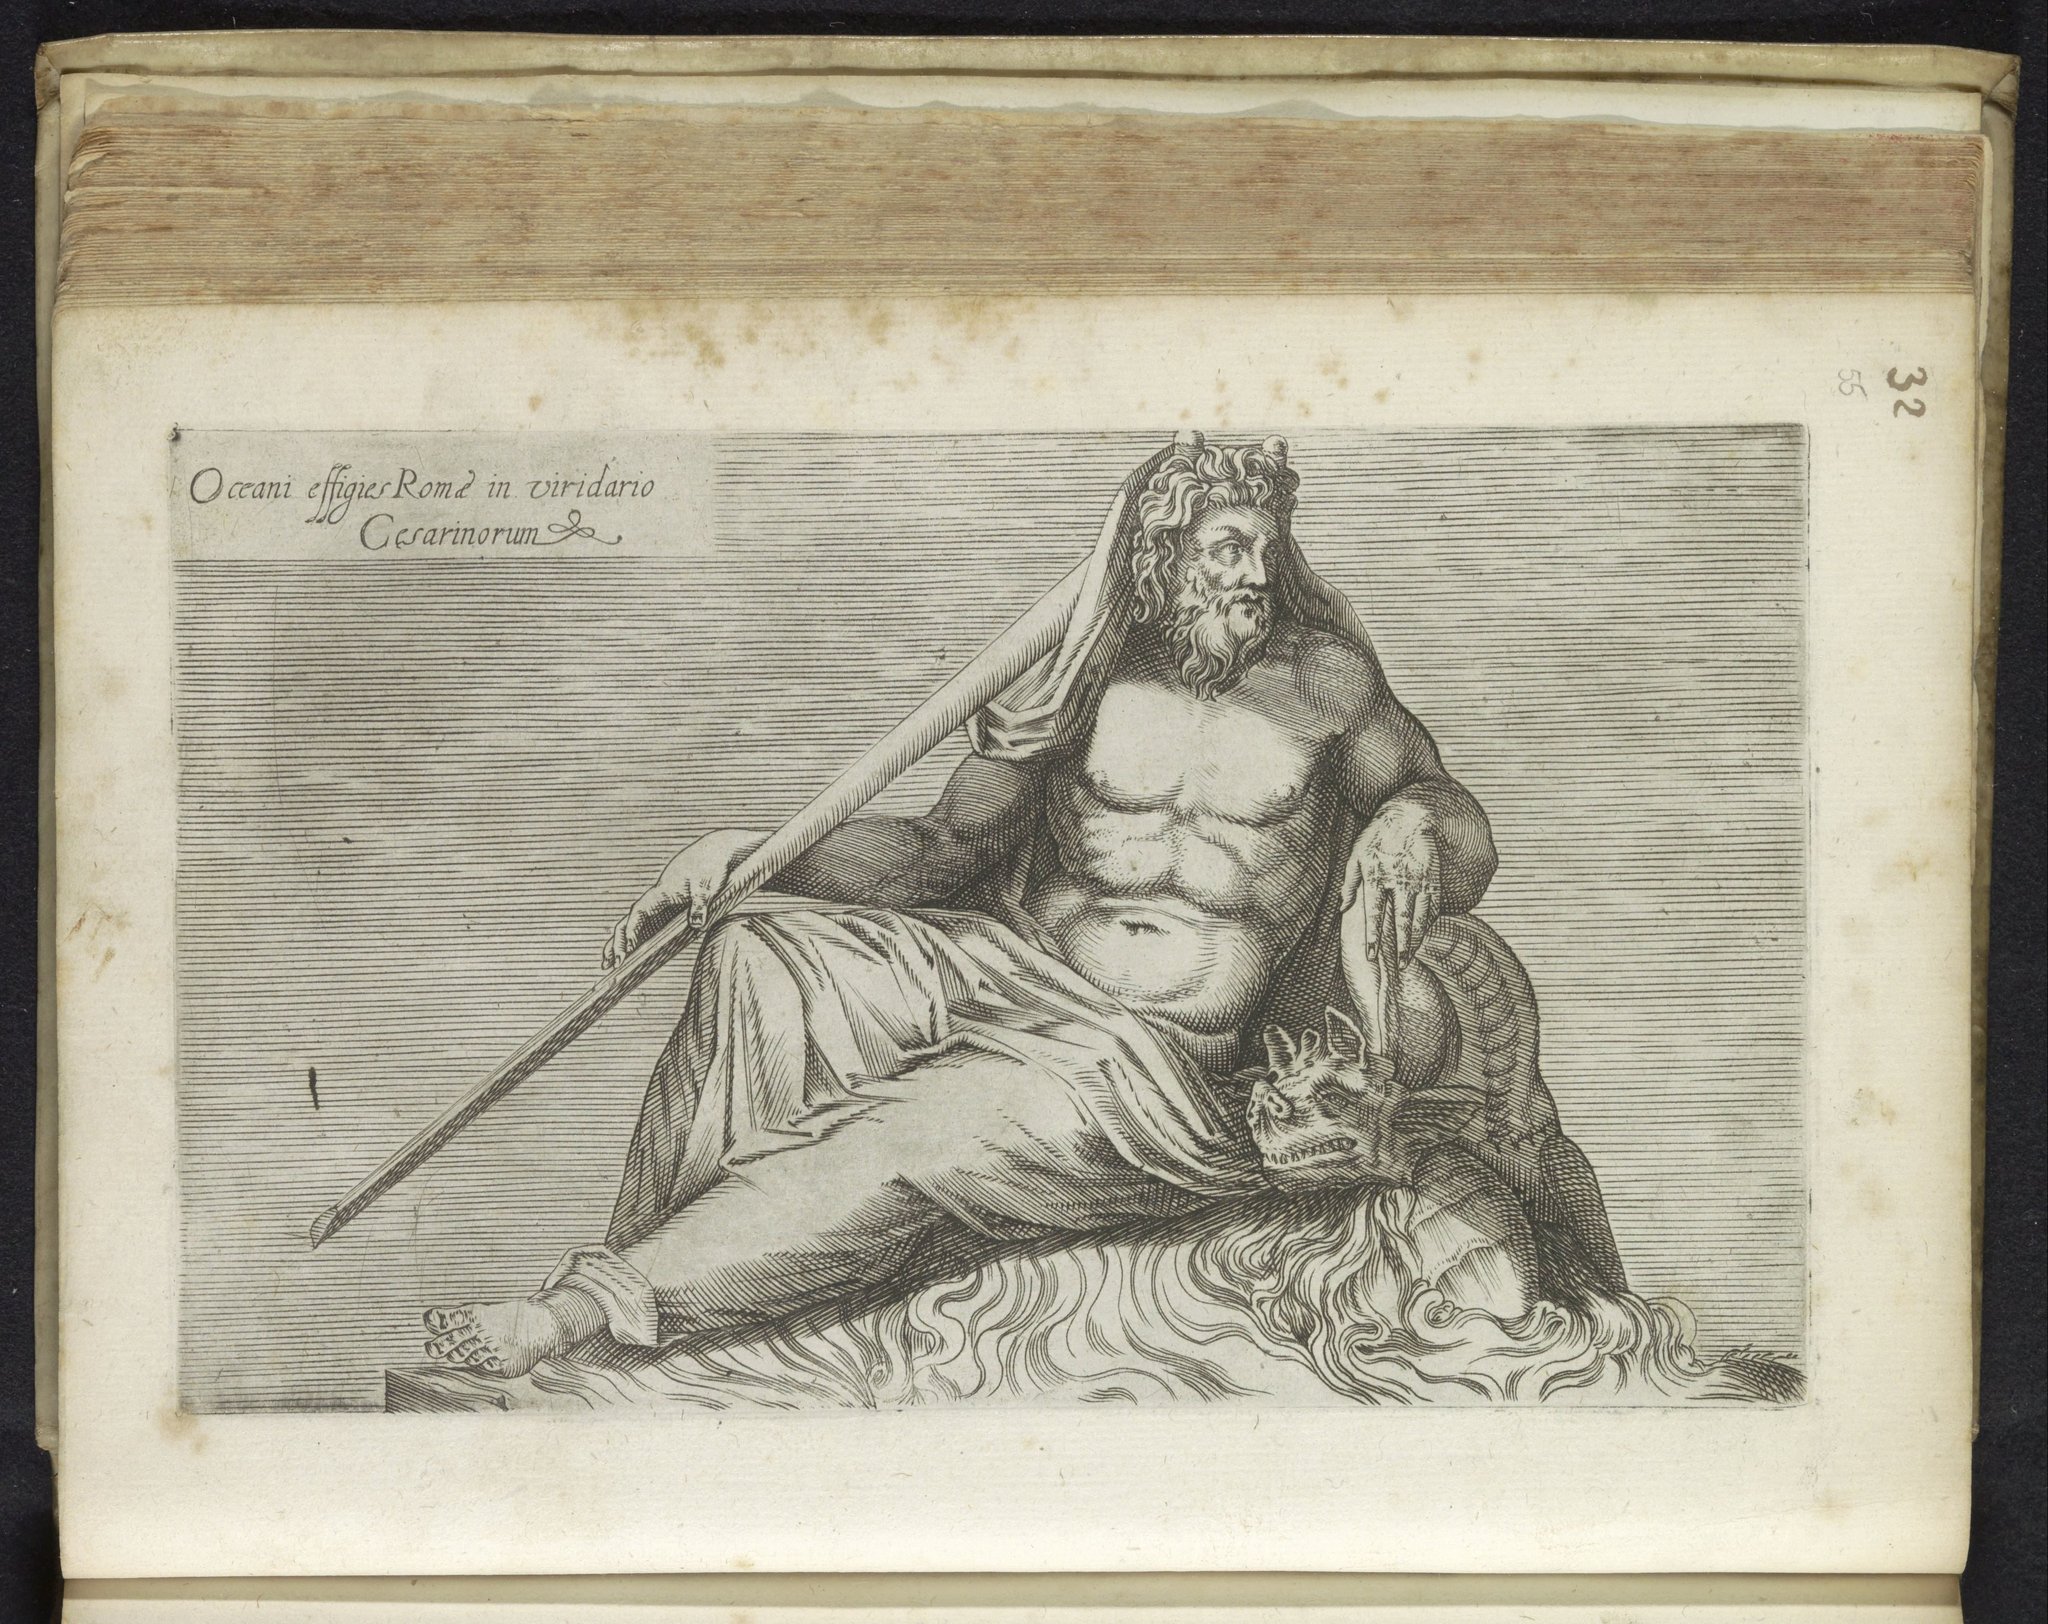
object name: album leaf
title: Antiquarum statuarum urbis Romae quae in publicis locis visuntur icones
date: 1584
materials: paper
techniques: engraving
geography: rome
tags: (story of) oceanus, piece of sculpture, reproduction of a piece of sculpture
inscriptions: number: ‘32’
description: Deze prent maakt deel uit van een set van 79 prenten (+ titelprent) met voorstellingen van antieke sculpturen in Rome.